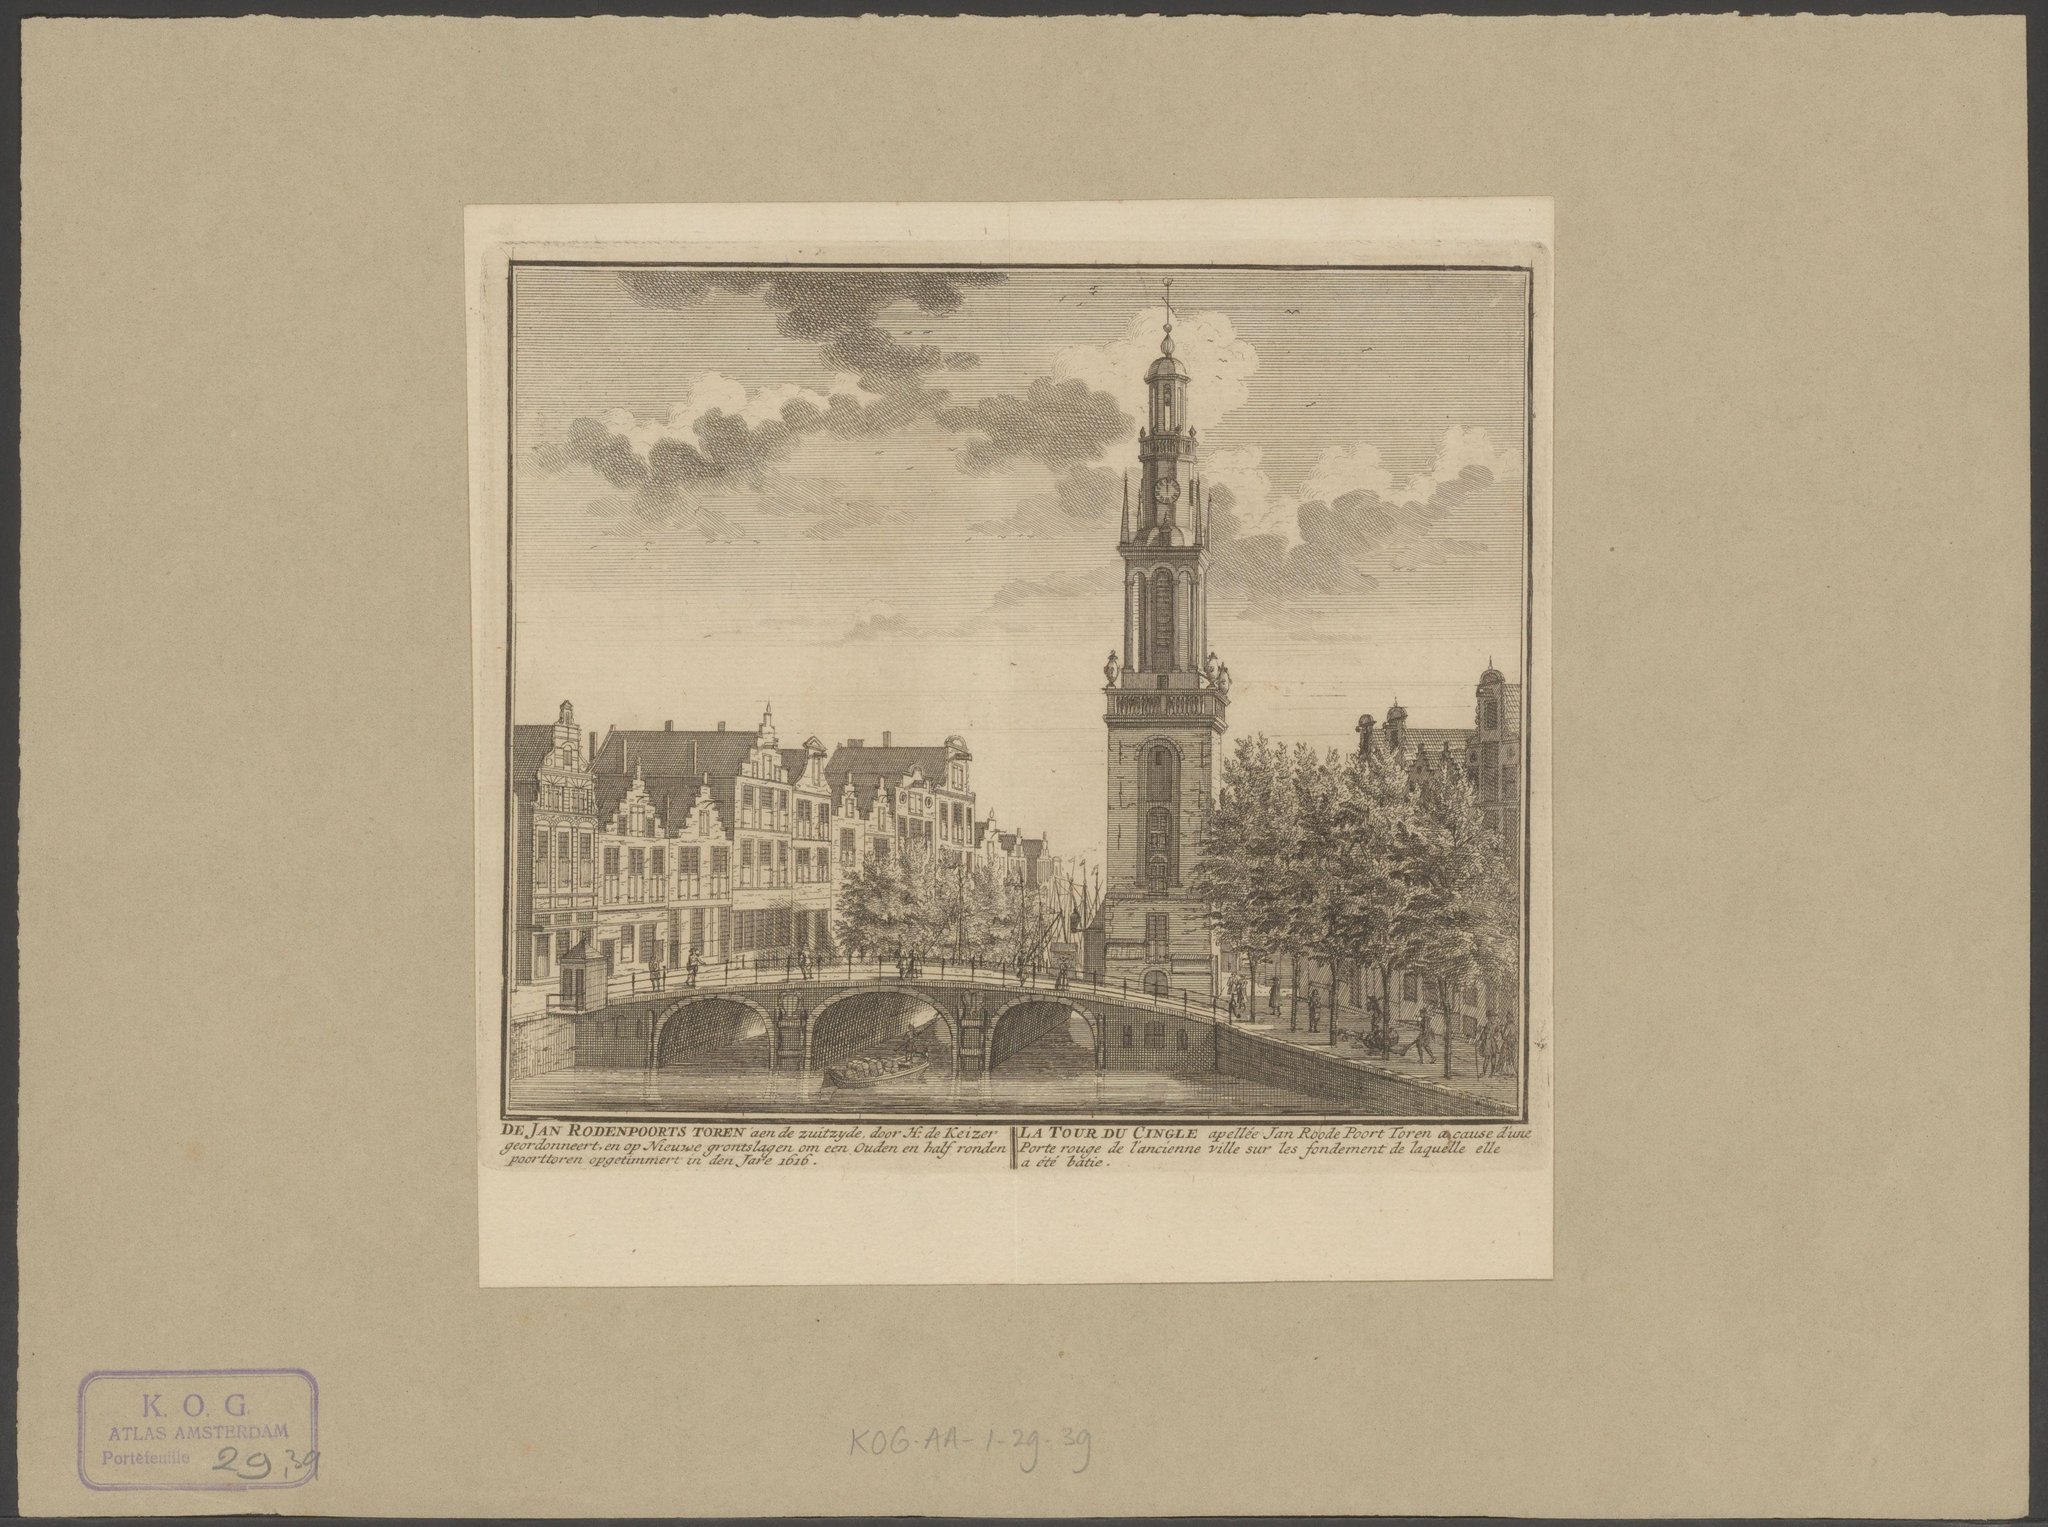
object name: print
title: De Jan Rodenpoorts Toren aen de zuitzyde, door H: de Keizer geordonneert, en op Nieuwe grontslagen om een Ouden en half ronden poorttoren opgetimmert in de Jare 1616 / La Tour du Cingle apellée Jan Roode Poort Toren a cause d'une Porte rouge de l'ancienne ville sur les fondement de laquelle elle a été batie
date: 1740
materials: paper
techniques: engraving, etching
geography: amsterdam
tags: utrecht, amsterdam, print maker, hendrick de keyser (i), tower, clock tower ~ monumental adornment, bridge in city across river, canal, etc., canals, waters (in city) (+ city(-scape) with figures, staffage)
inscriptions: collector's mark: Lugt 1641b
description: Prent mogelijk uit: Description de la fameuse ville d'Amsterdam (...) / Afbeeldinge van de wydt-vermaarde stadt Amsterdam (...). Amsterdam: Hendrik de Leth, [ca. 1740].